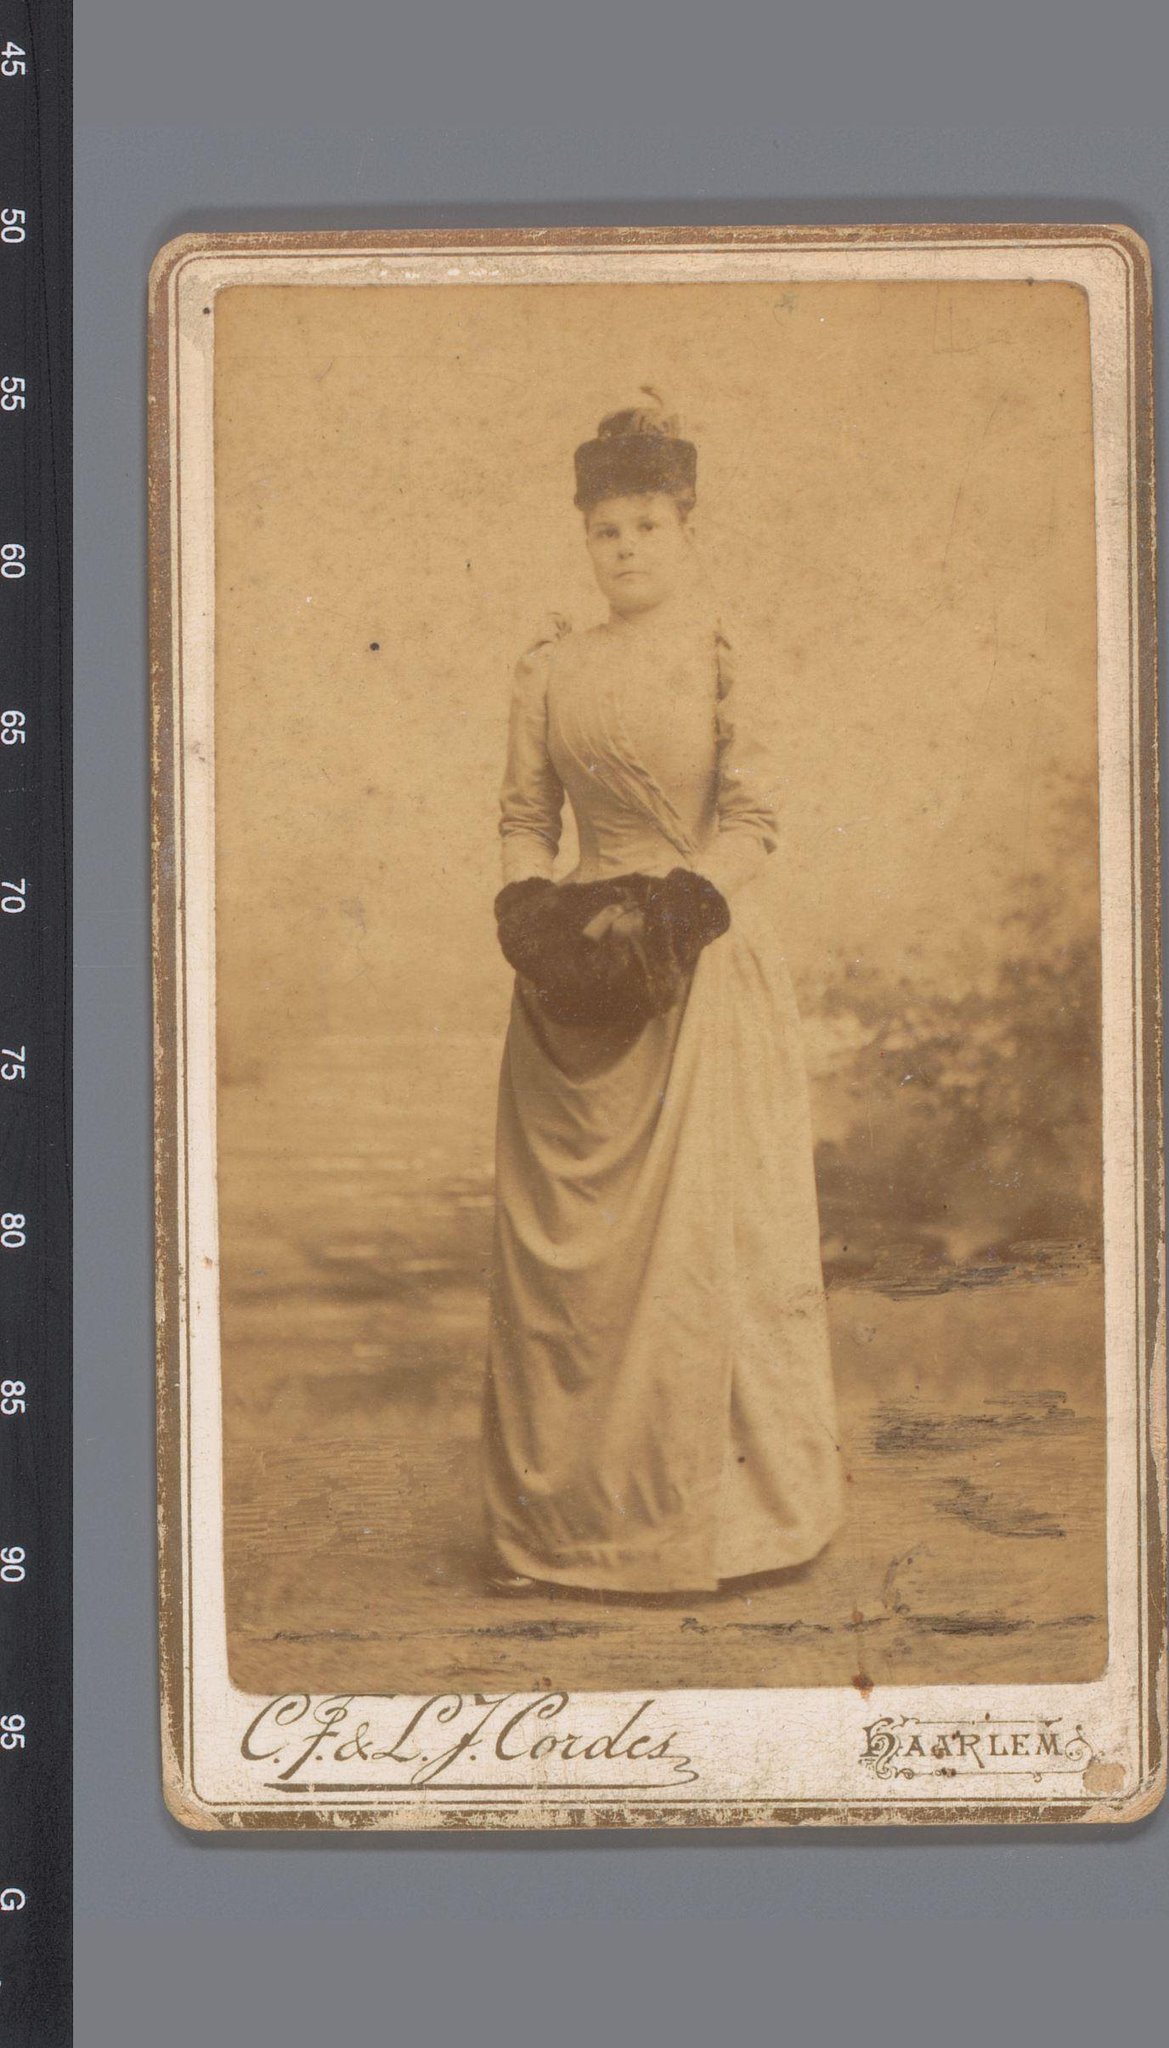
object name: carte de visite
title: Portret van een onbekende jonge vrouw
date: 1888-1901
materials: cardboard, paper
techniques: albumen print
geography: haarlem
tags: adolescent, young woman, maiden, anonymous historical person portrayed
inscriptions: address: ‘Haarlem/ Groote Houtstraat 84./ 's Bosch a/d Parade.’, inscription: ‘Op verschillende tentoonstellingen bekroond voor Vergrootingen (...)’